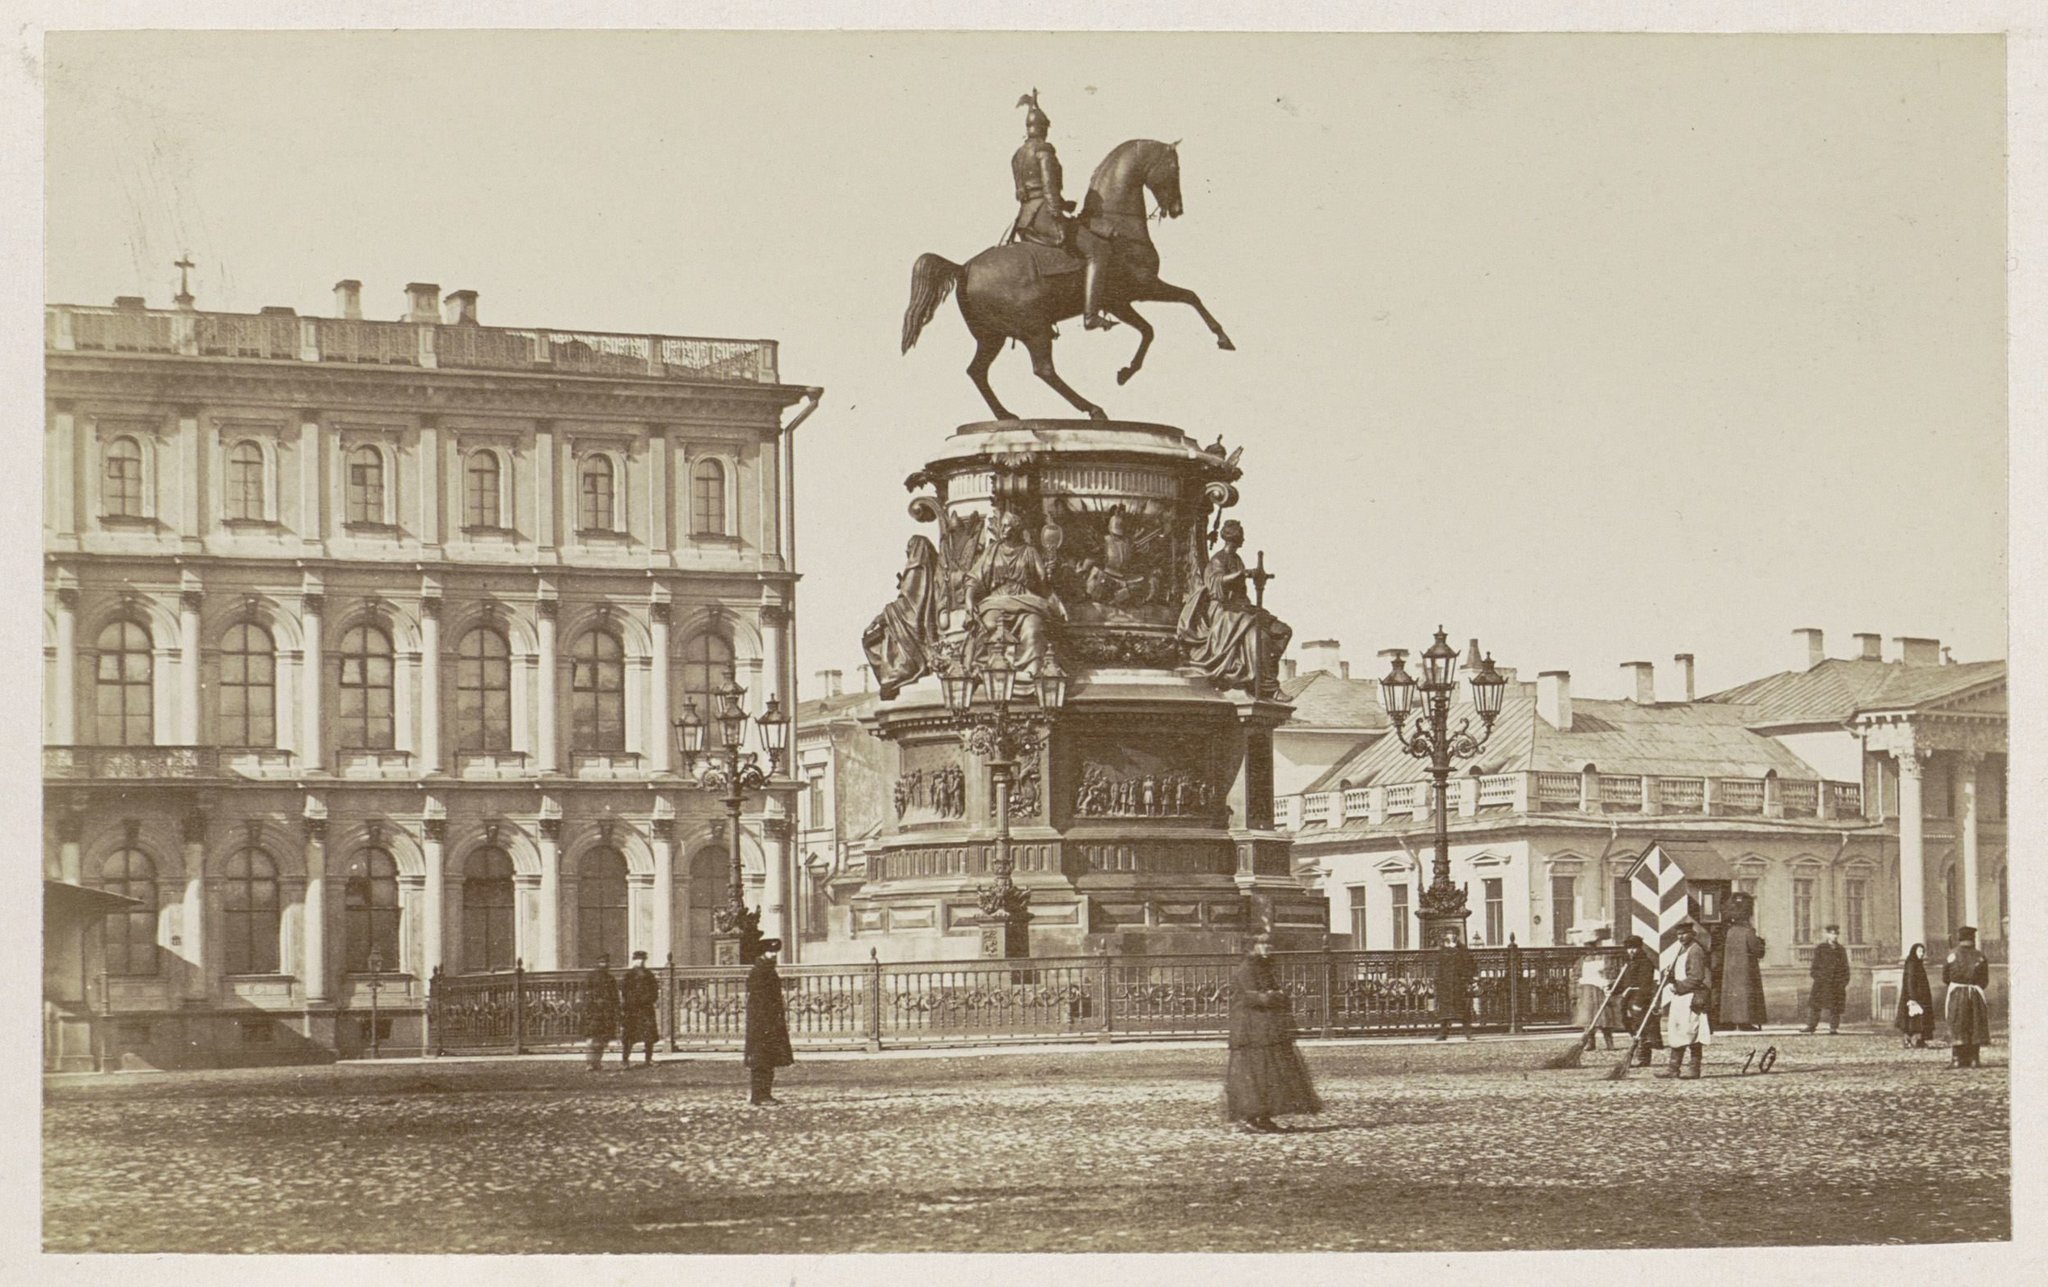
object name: photograph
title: Monument voor Nicolaas I in Sint Petersburg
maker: Anonymous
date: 1878-1890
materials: photographic support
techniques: albumen print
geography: sint-petersburg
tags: equestrian statue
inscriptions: negative number: ‘10’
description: Onderdeel van Reisalbum Europese steden, vermoedelijk Zweeds.